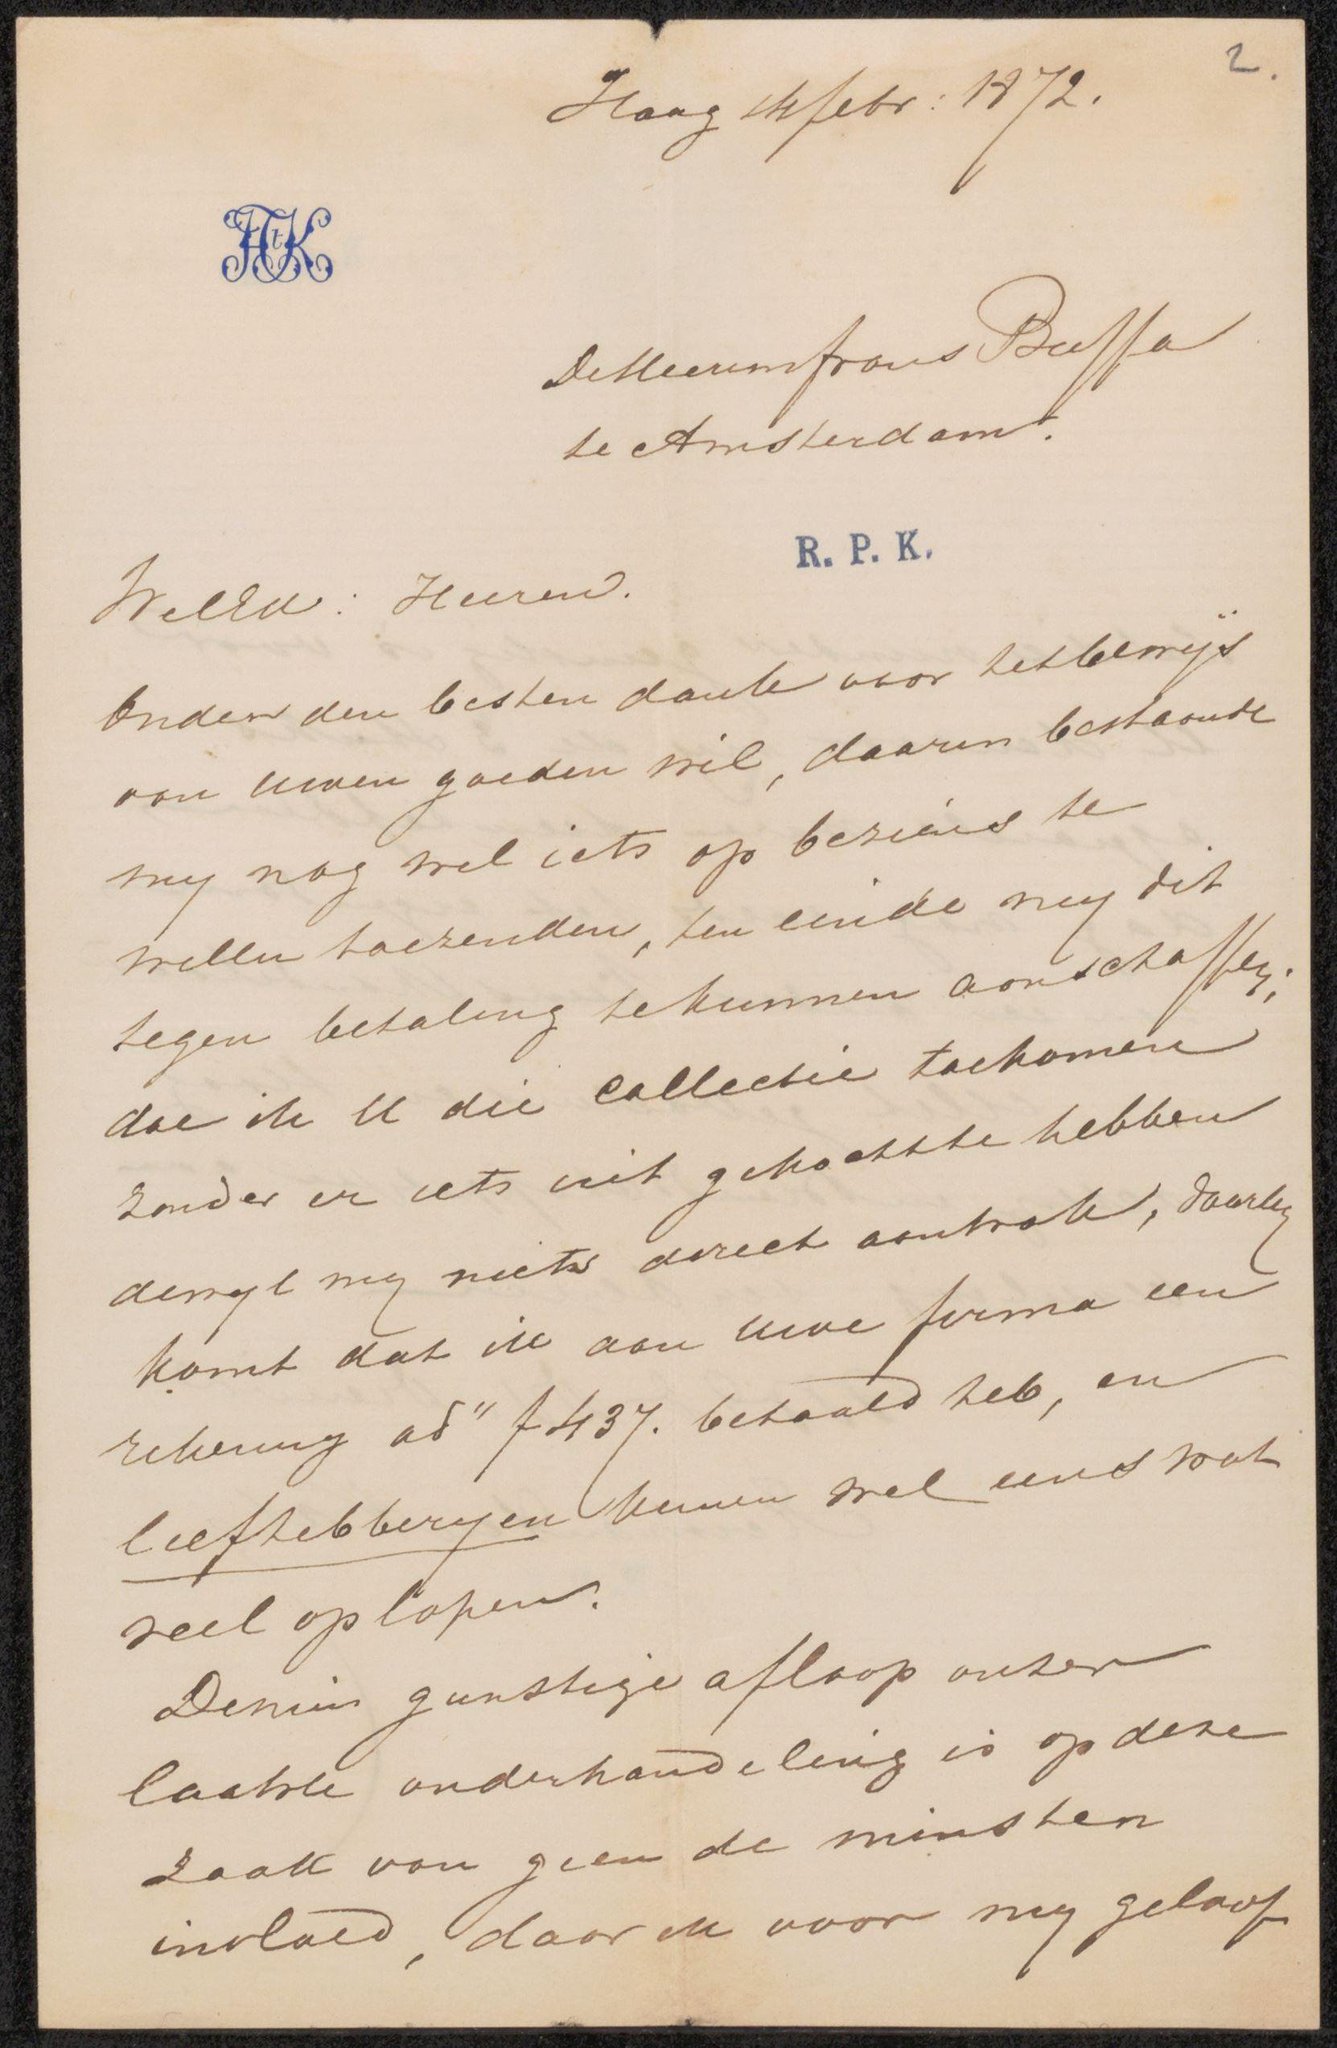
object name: letter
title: Brief aan Frans Buffa en Zonen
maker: herman frederik carel ten kate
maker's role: draughtsman, painter, print maker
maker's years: 1822-1891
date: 1872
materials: ink, paper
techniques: pen, printing, writing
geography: the hague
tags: publisher, art trade, art shop, drawing, money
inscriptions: collector's mark: Lugt 2233